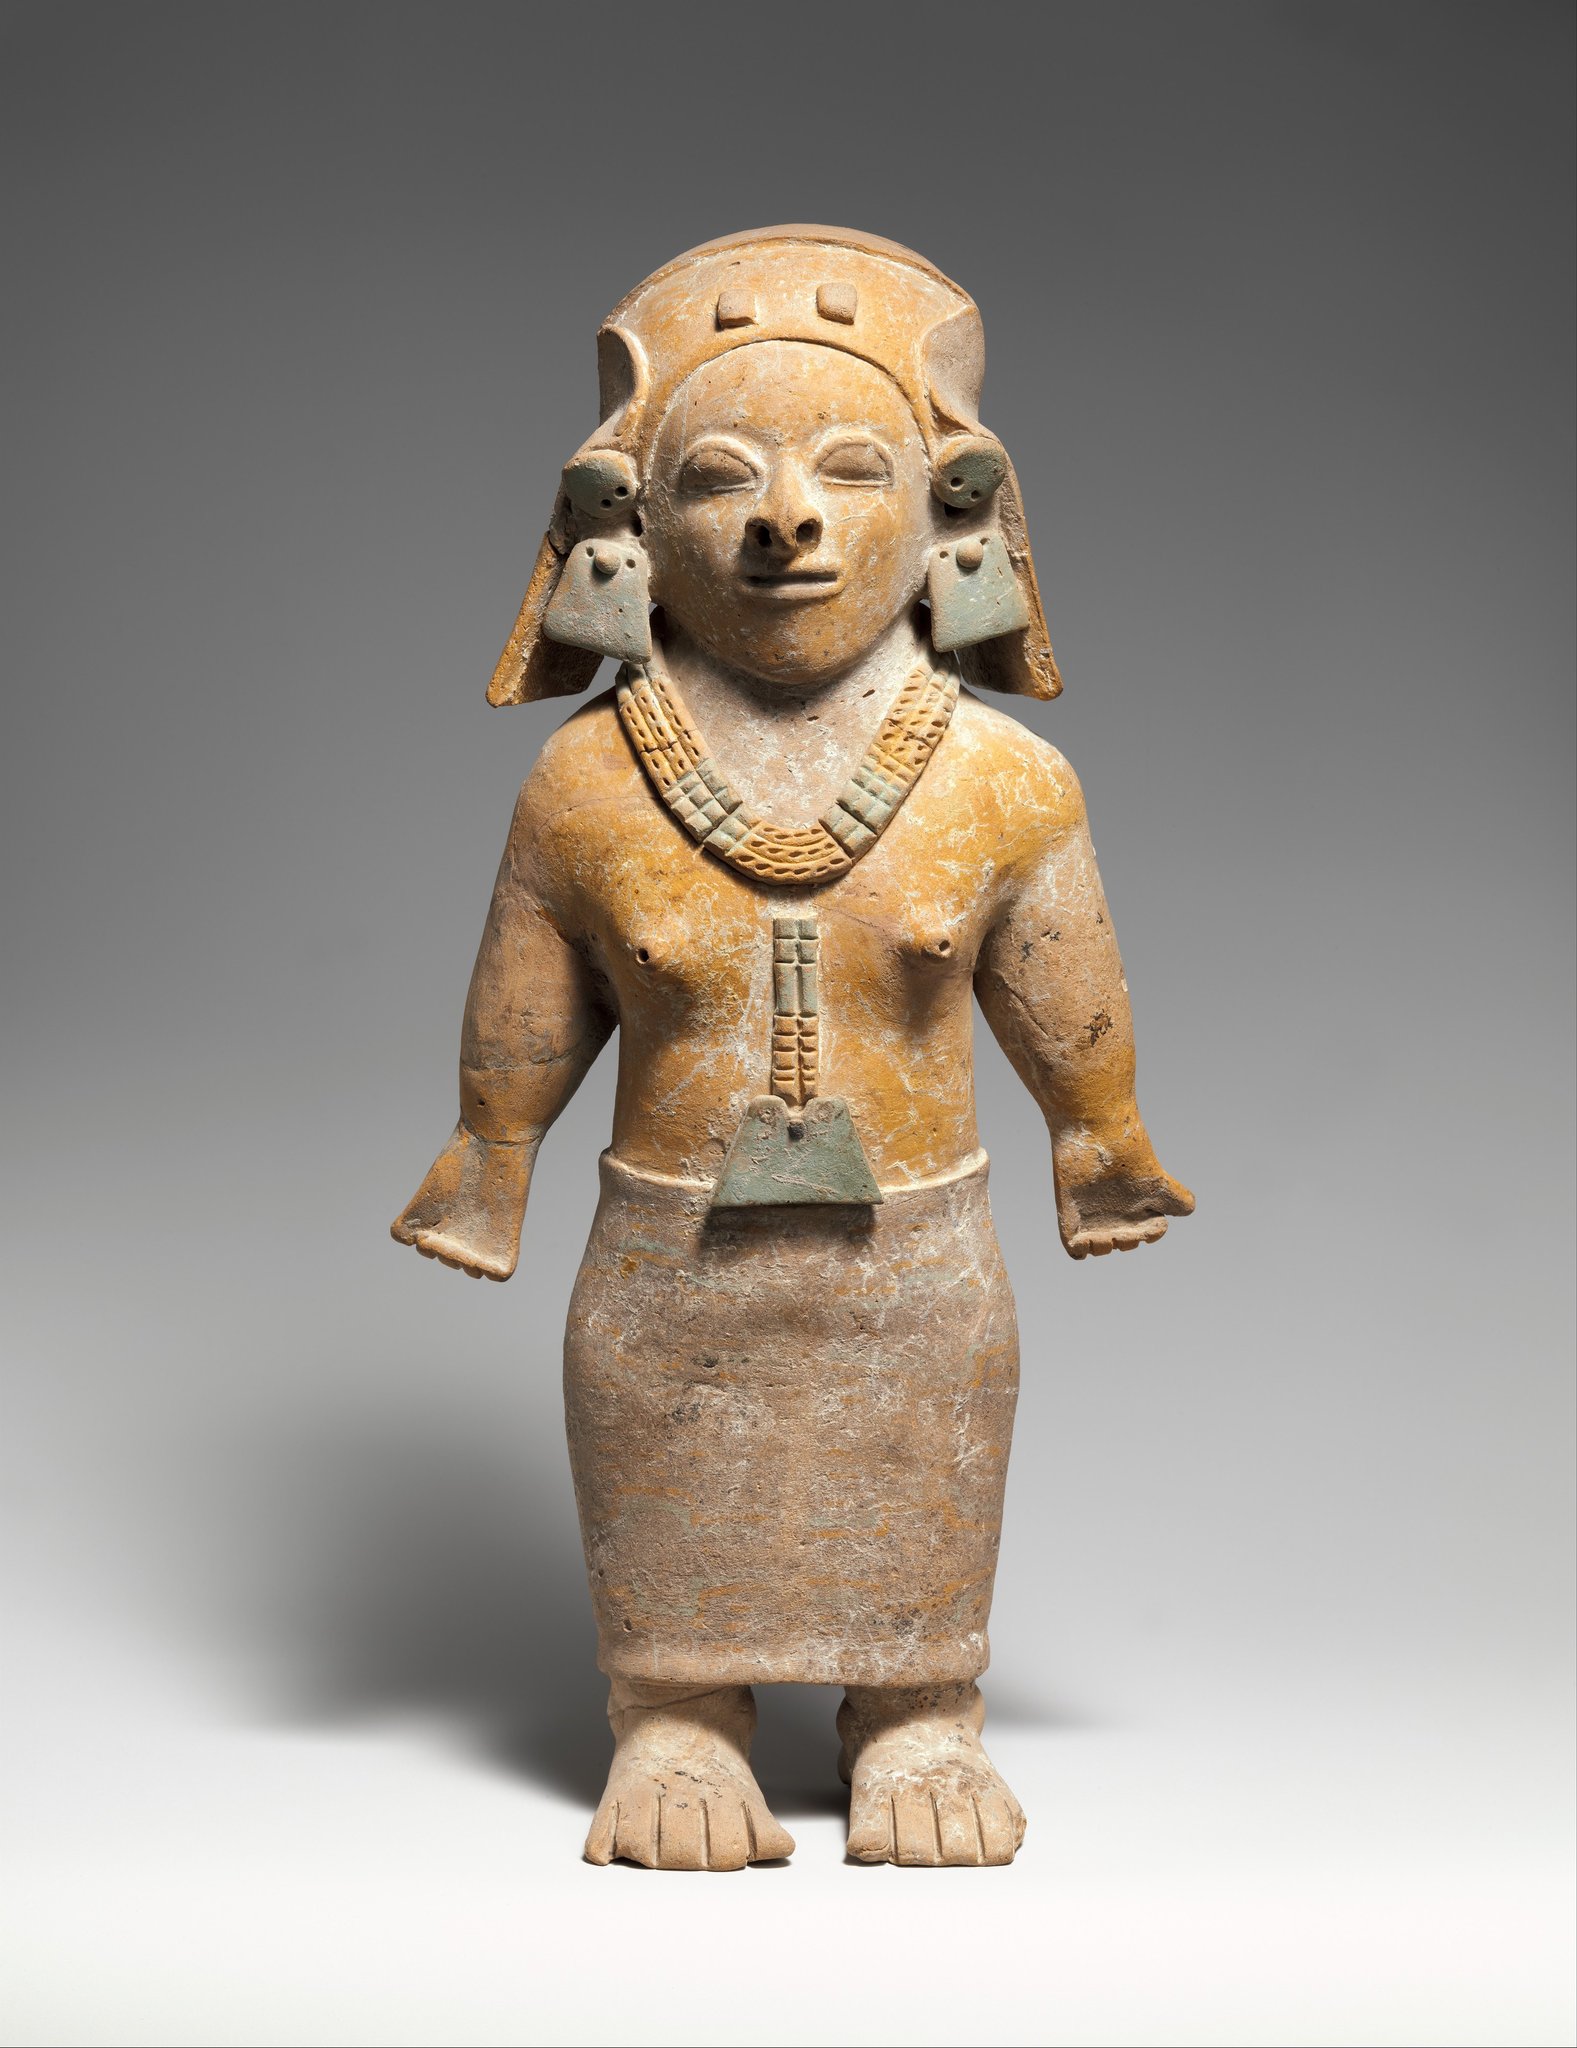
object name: female figure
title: Standing figure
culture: jama-coaque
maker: jama-coaque artist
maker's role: artist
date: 240 BCE-450 CE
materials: ceramic, paint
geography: ecuador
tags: women